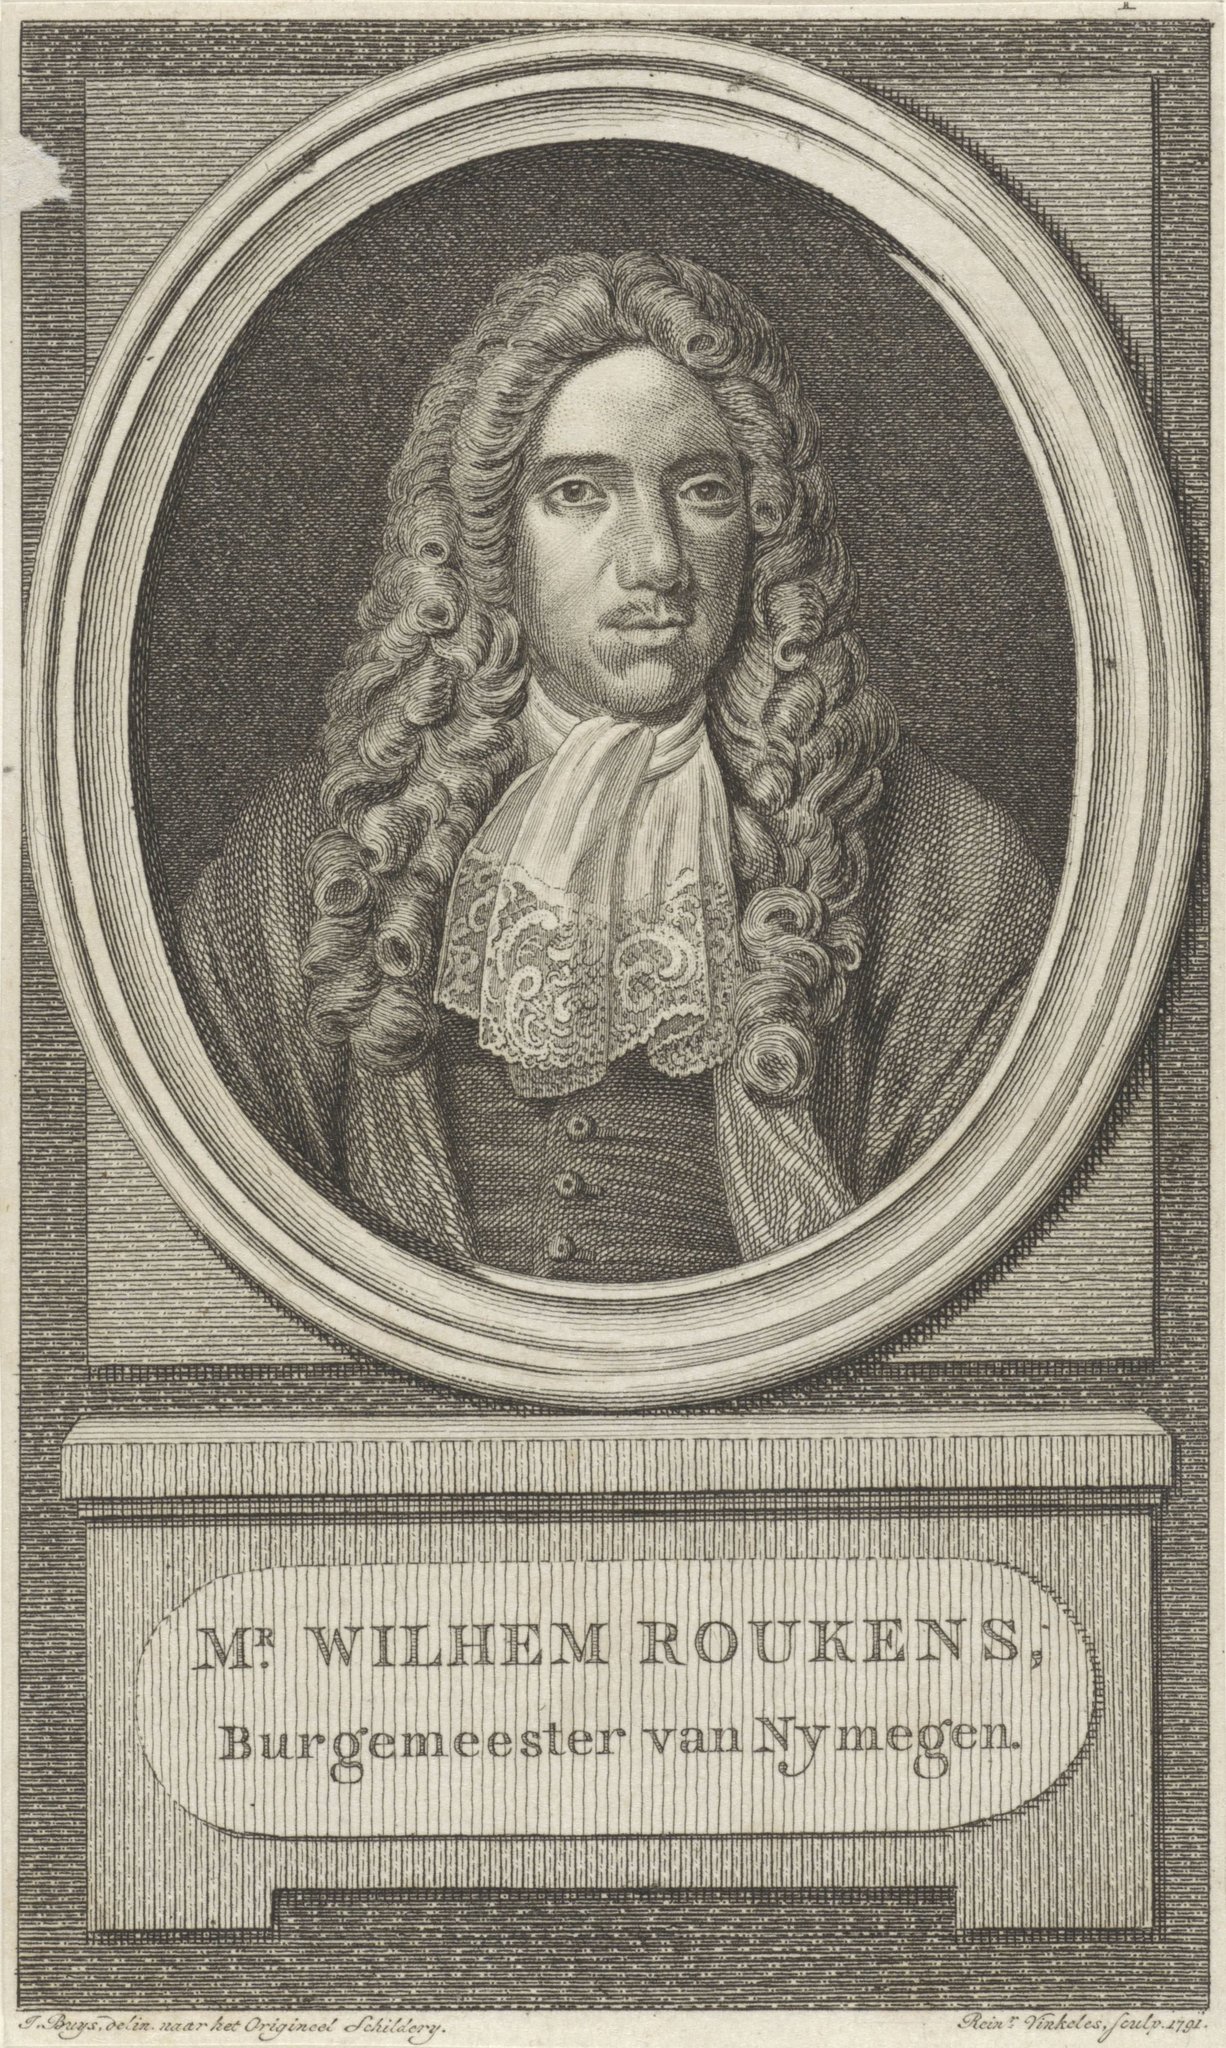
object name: print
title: Portret van Willem Roukens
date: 1791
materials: paper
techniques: engraving, etching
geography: amsterdam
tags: mayor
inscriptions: collector's mark: Lugt 2228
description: Prent gebruikt als boekillustratie in: Kok, Jacobus. Vaderlandsch woordenboek : met kaarten, plaaten en pourtraitten. Amsterdam: Johannes Allart, 1785-1796. Deel XXV.